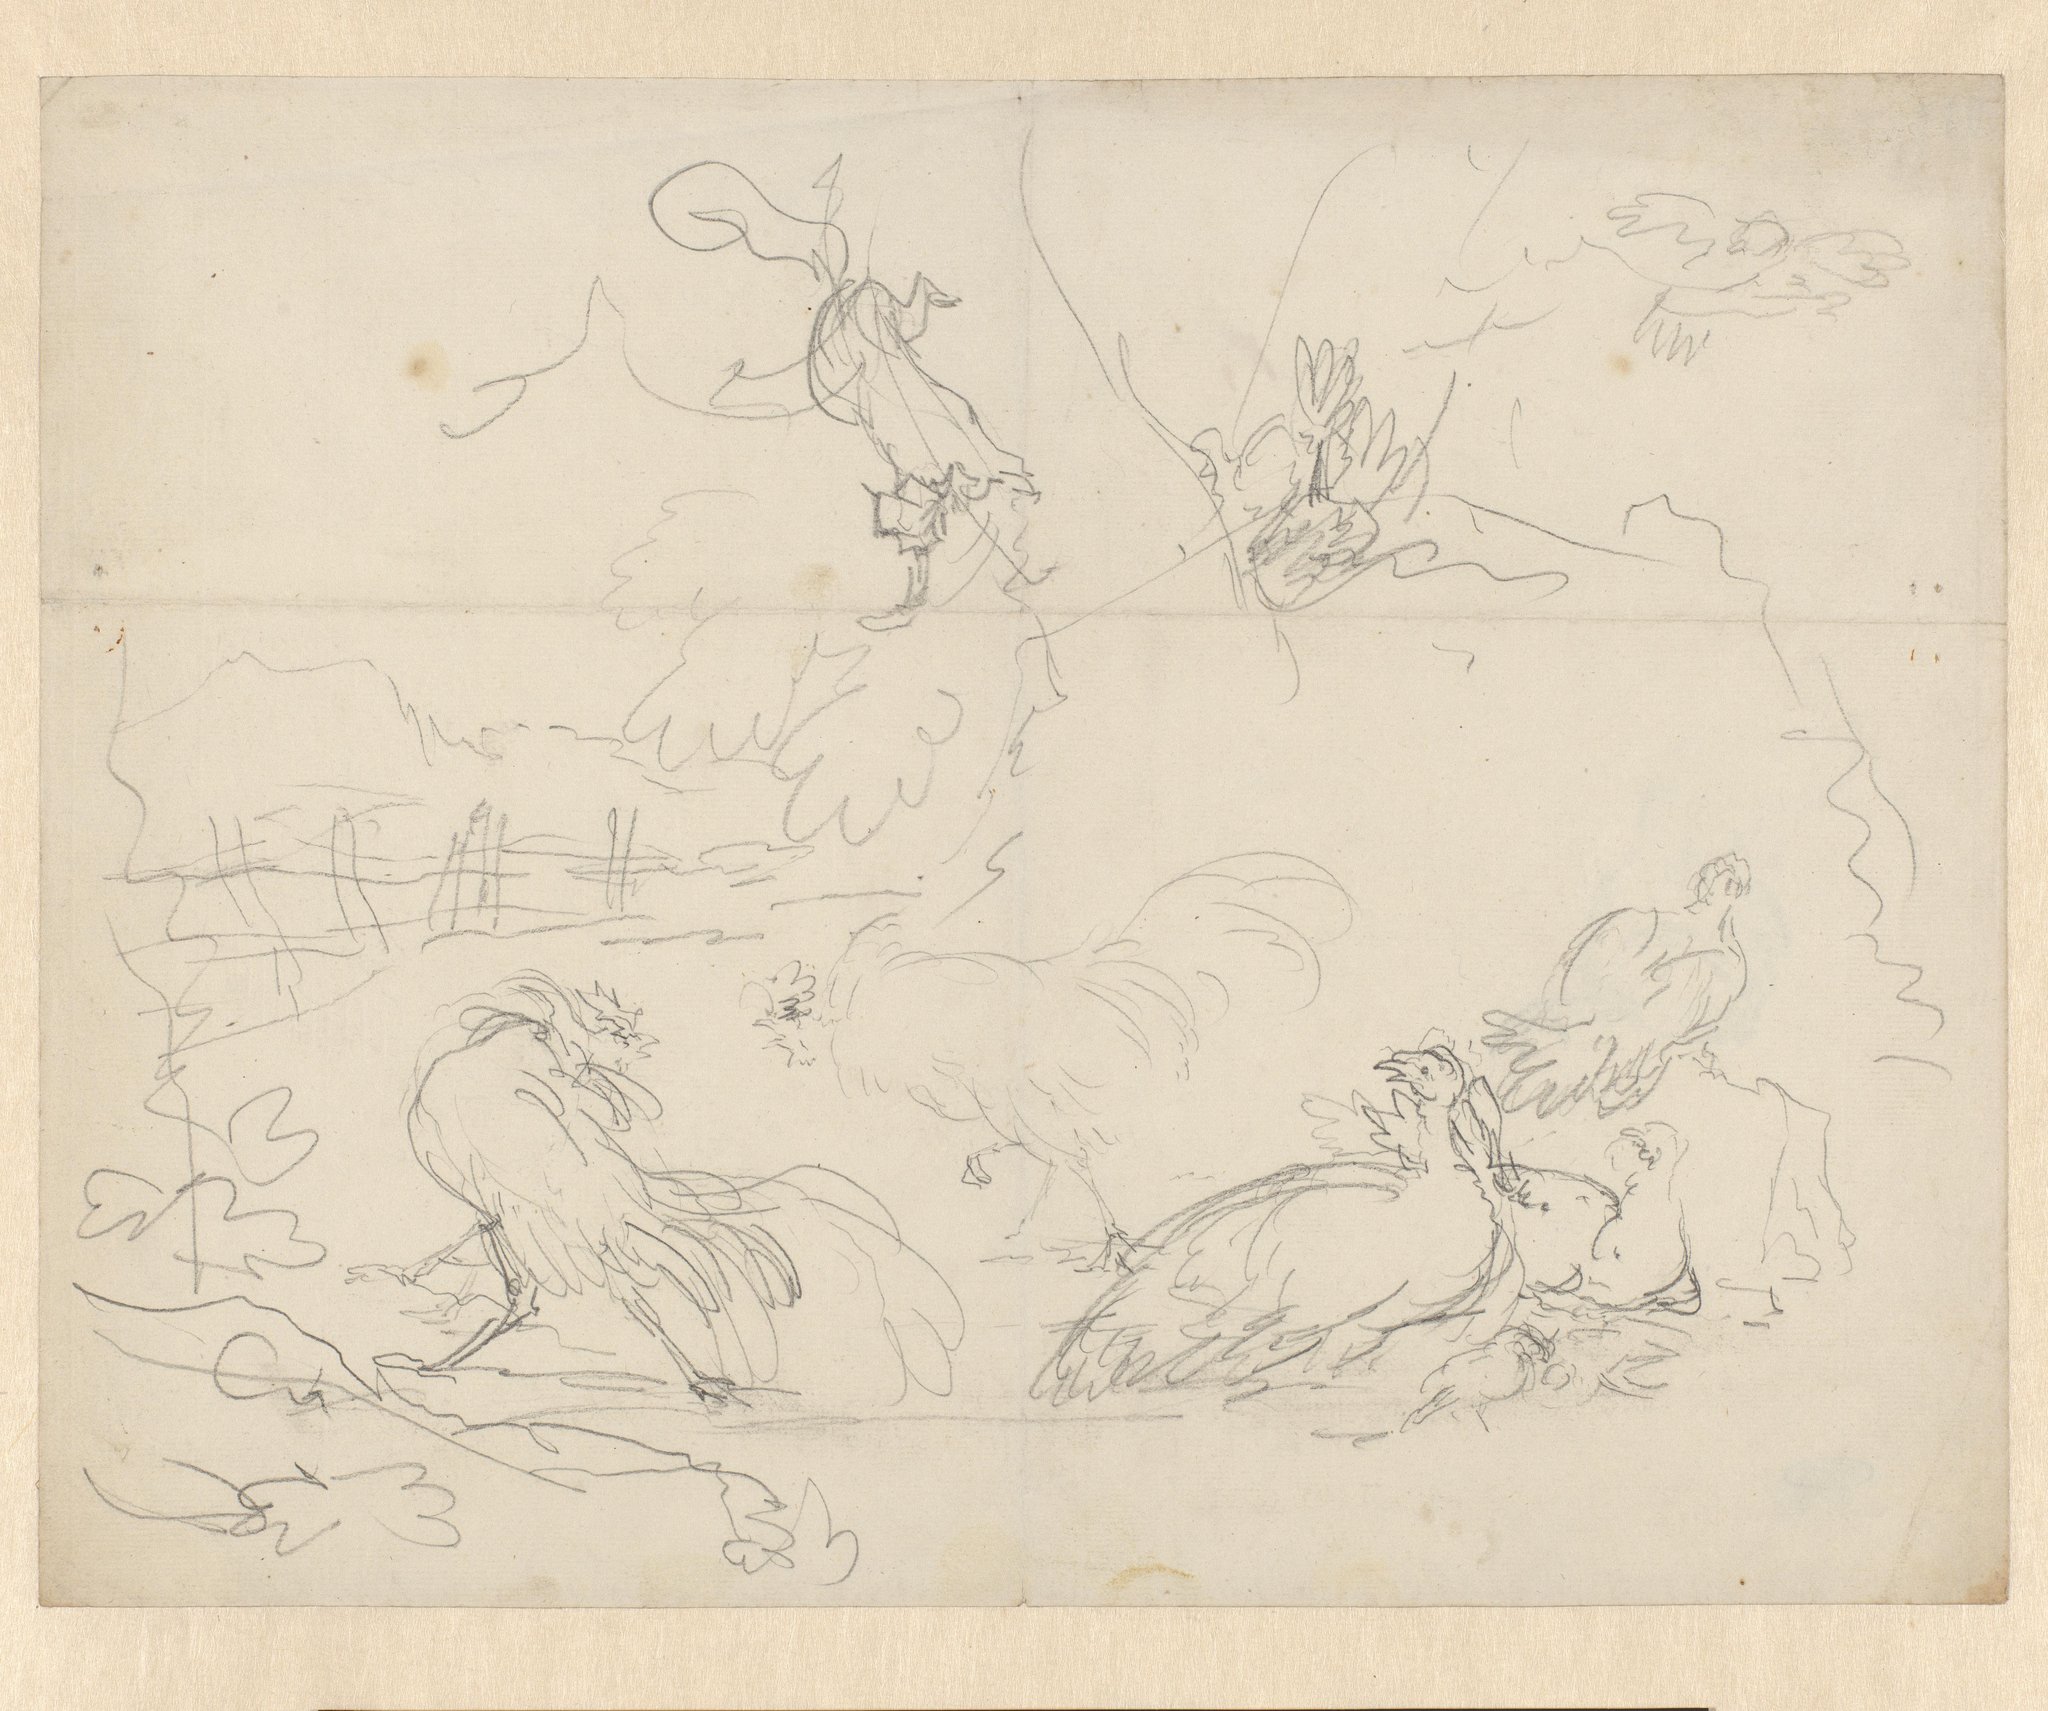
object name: drawing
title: Studies van vechtende hanen en kippen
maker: aert schouman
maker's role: draughtsman, painter, print maker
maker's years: 1710-1792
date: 1720-1792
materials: chalk, paper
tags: fowl (cock, hen, chicken, etc.)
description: Studieblad met vechtende hanen en kippen. Verso: een kuiken.